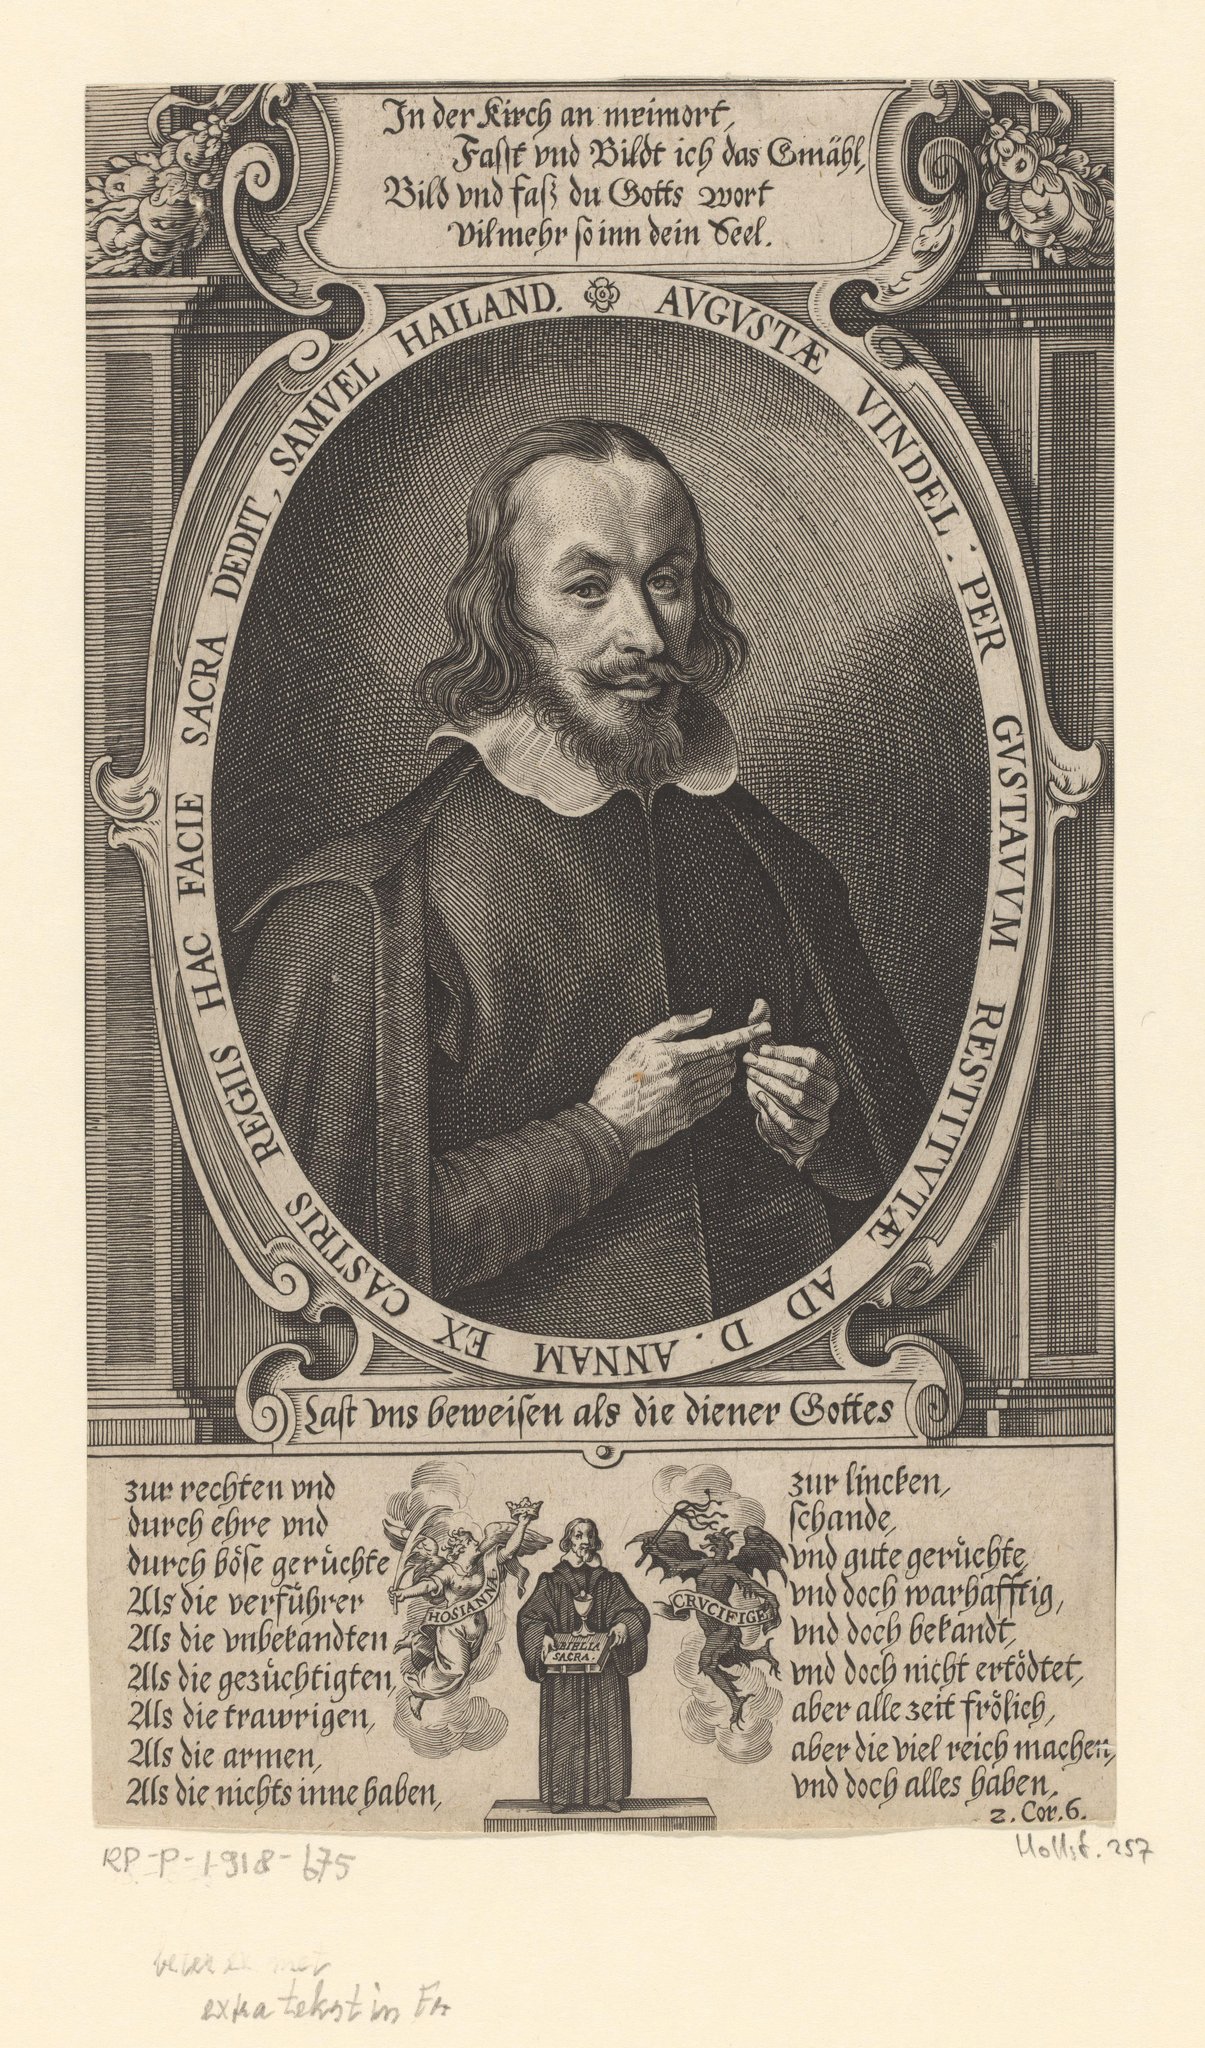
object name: print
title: Portret van Samuel Heiland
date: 1589-1637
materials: paper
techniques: engraving, etching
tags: theologian, historical persons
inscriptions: collector's mark: Lugt 2233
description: Tekst in het Latijn in de omlijsting, en tekst in het Duits de cartouche en in de ondermarge.